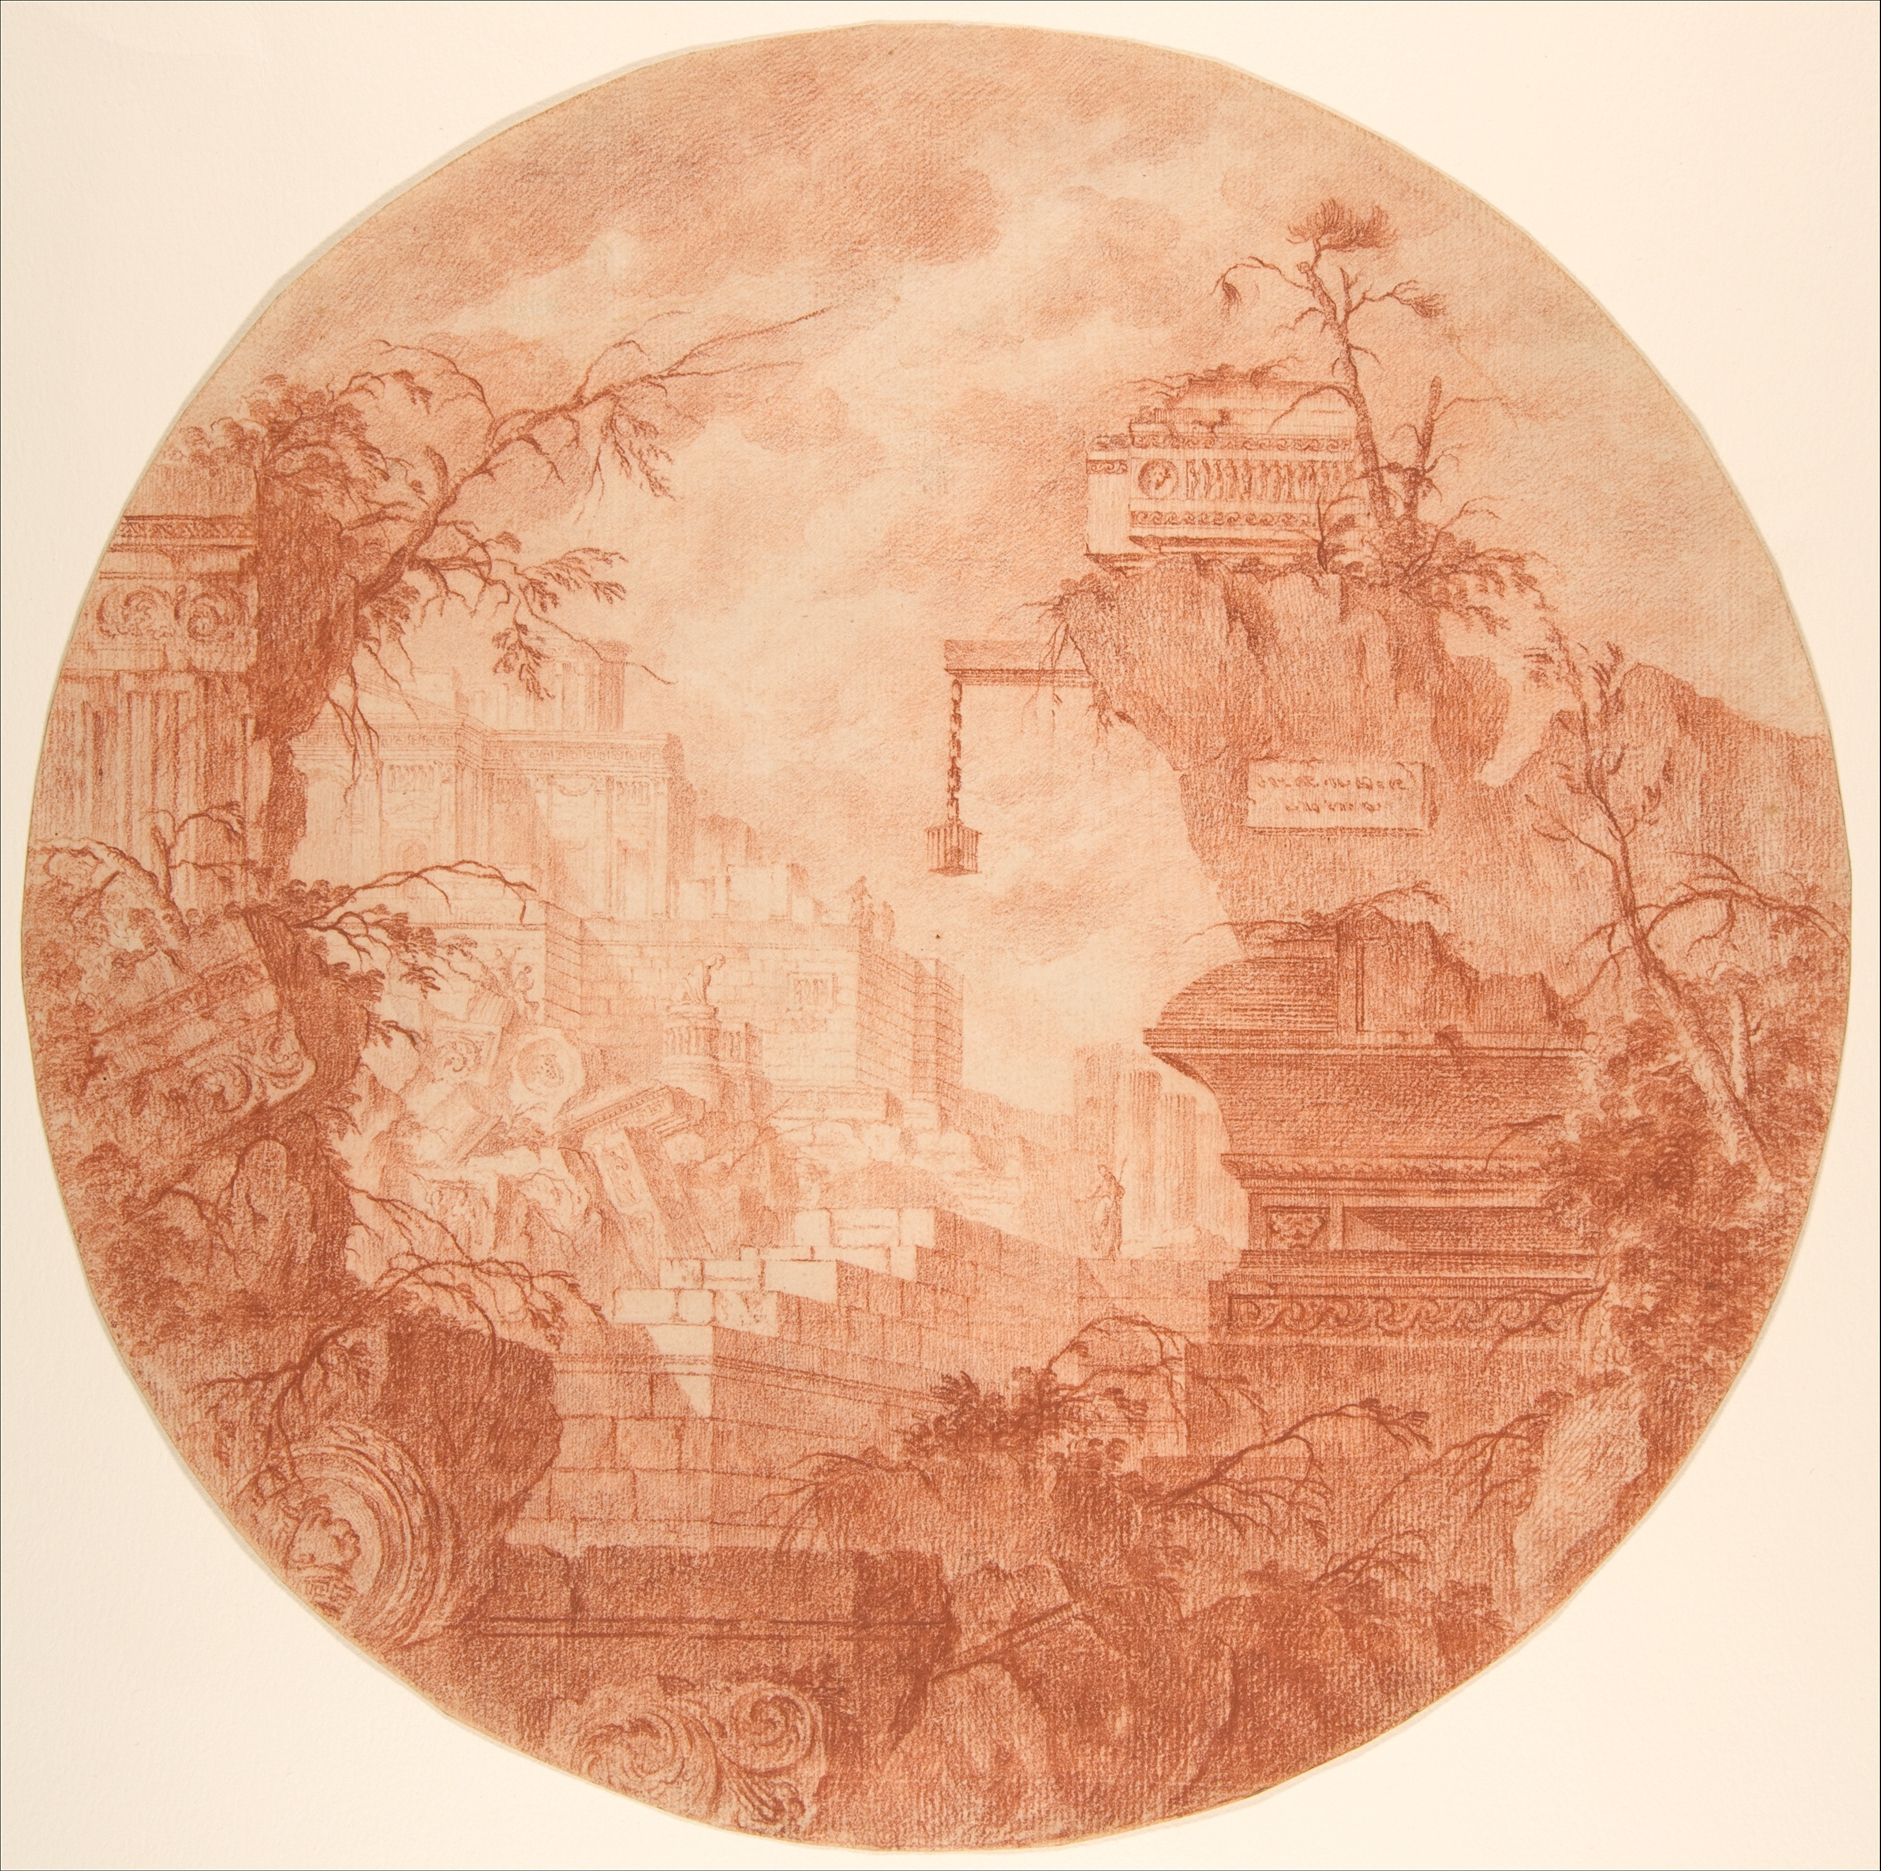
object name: drawing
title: Architectural Fantasy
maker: jean laurent legeay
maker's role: artist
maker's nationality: french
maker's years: 1710-1788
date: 1785-1790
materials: chalk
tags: architecture,ruins,trees